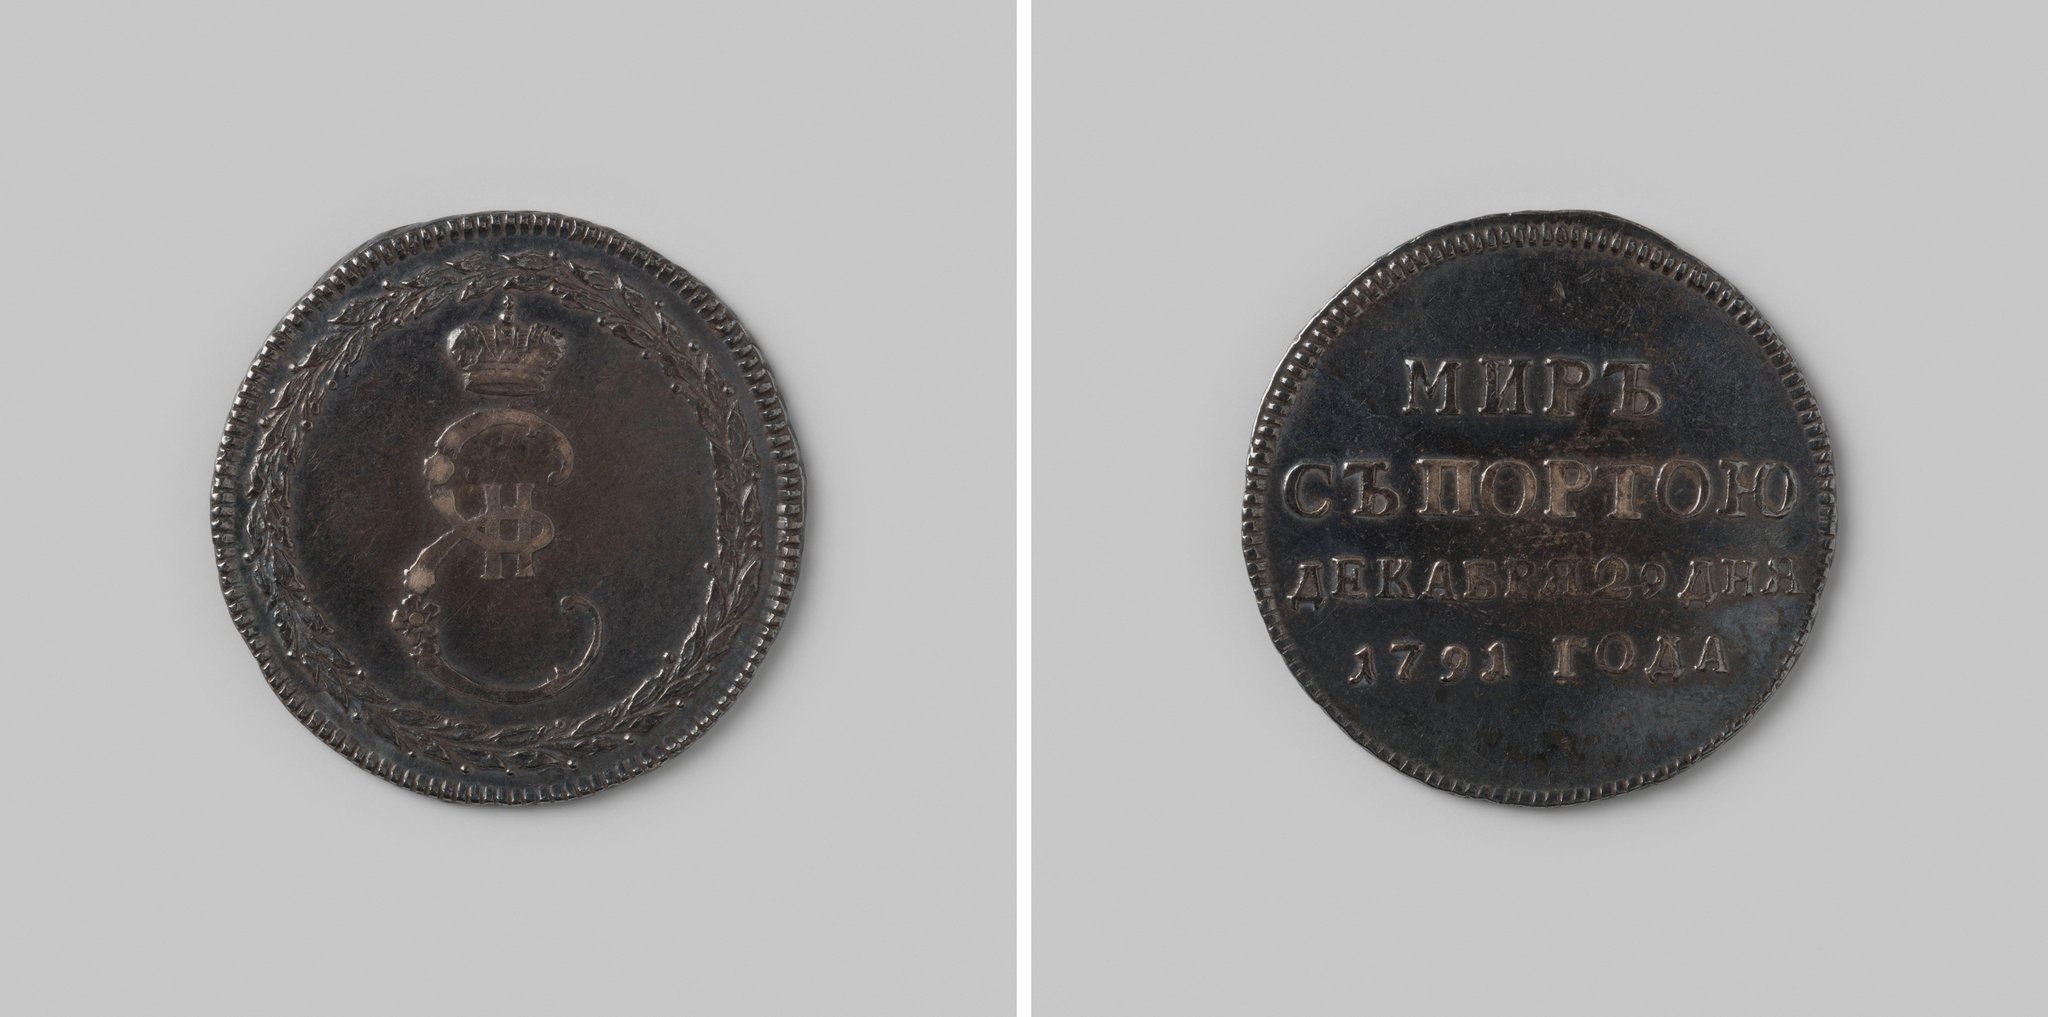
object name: history medal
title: Vrede van Rusland met Turkije 1791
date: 1791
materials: silver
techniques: striking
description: Zilveren penning, op de voorzijde een gekroond E II monogram in een lauwerkrans, op de keerzijde vier regels tekst.